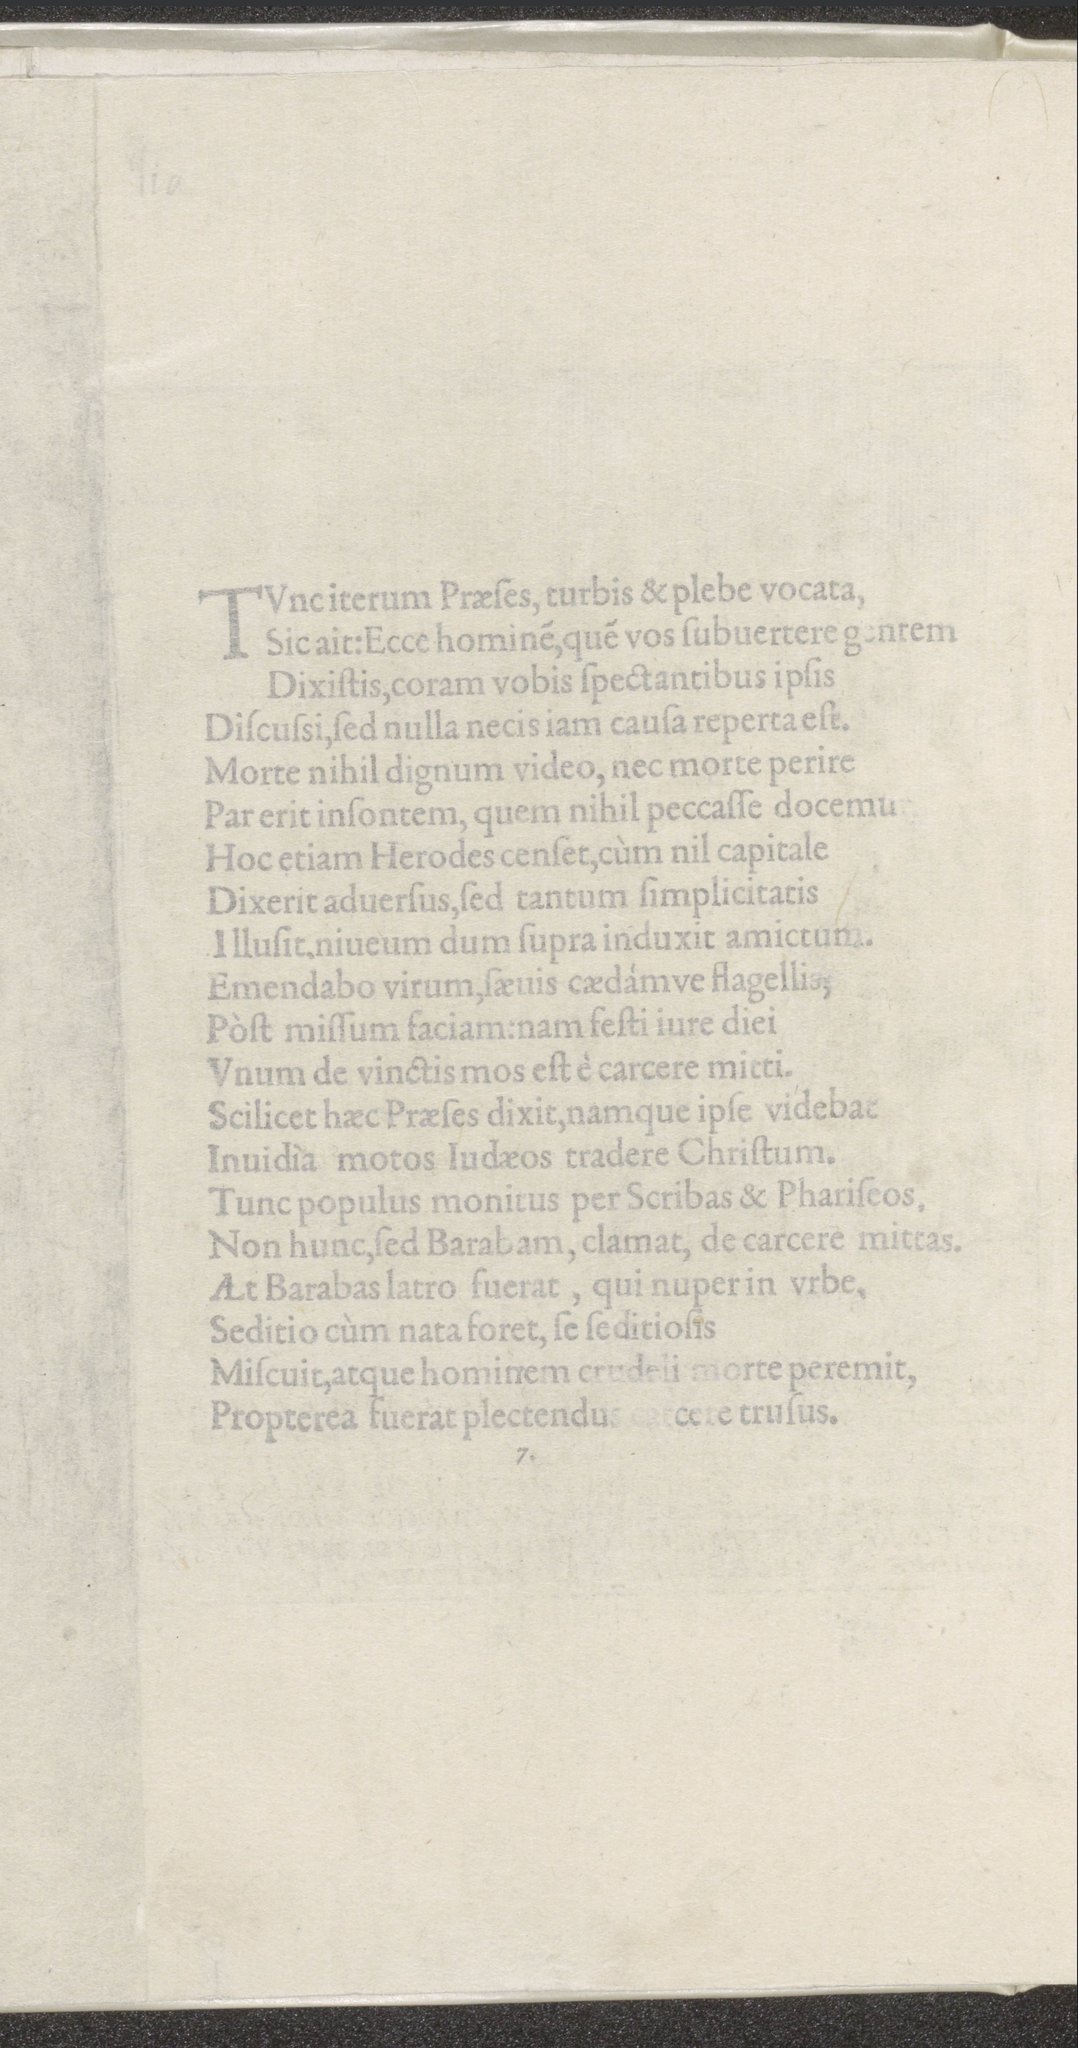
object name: album leaf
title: Mnimata Dominicae Passionis Historiam Necisque Nostrae Mortem Complexa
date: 1572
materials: paper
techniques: letterpress printing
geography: antwerp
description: Tijdens de restauratie in 1988 bleek dat op de achterzijde van de prenten van de Passie-serie van Wierix Latijnse teksten in boekdruk staan. Deze vormen, wanneer op de juiste wijze in boekvorm gebonden (wat nu in het Heemskerck-album niet het geval is), een toelichting op de passievoorstellingen. Om de teksten zichtbaar te laten zijn de prenten bij de restauratie niet meer met de achterzijde op elkaar geplakt.